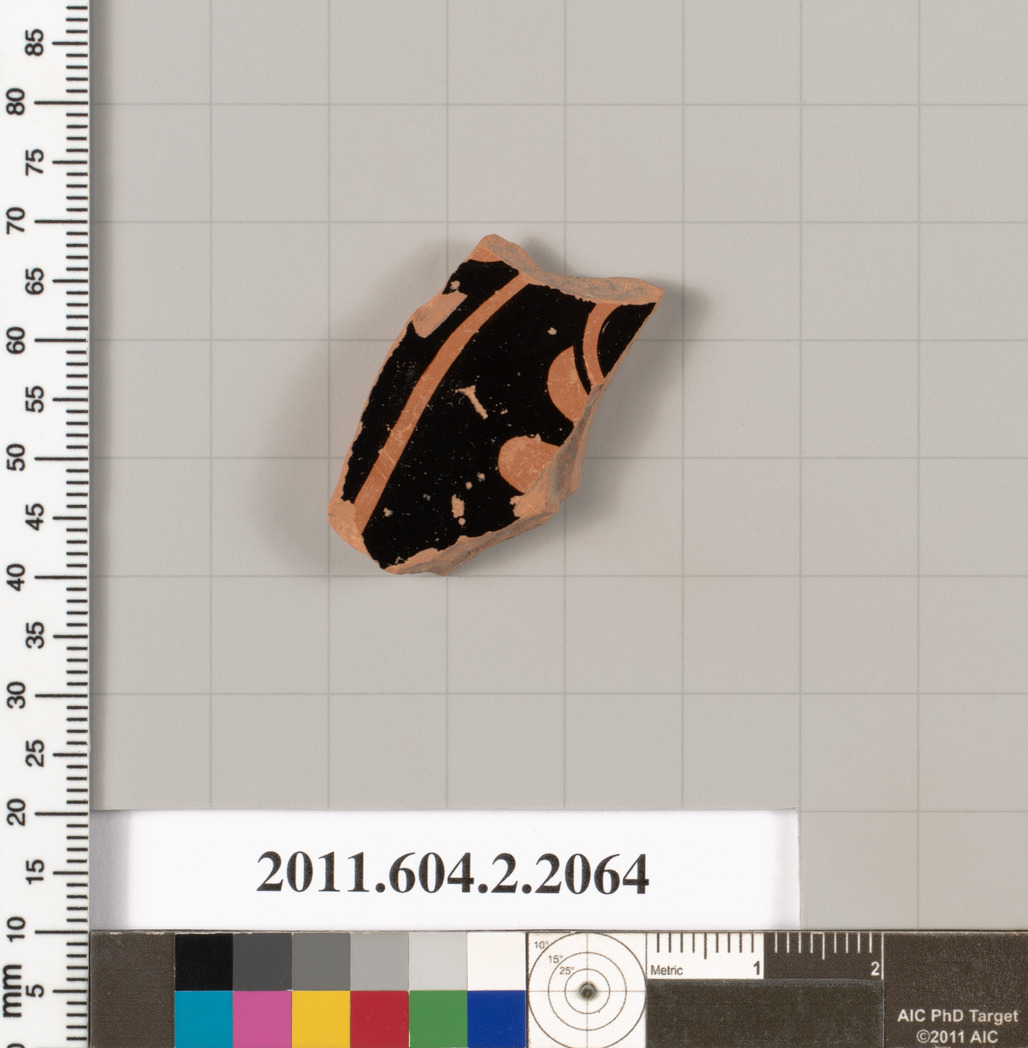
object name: stamnos fragment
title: Terracotta fragment of a stamnos (jar)?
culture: greek, attic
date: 475-451 BCE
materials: terracotta